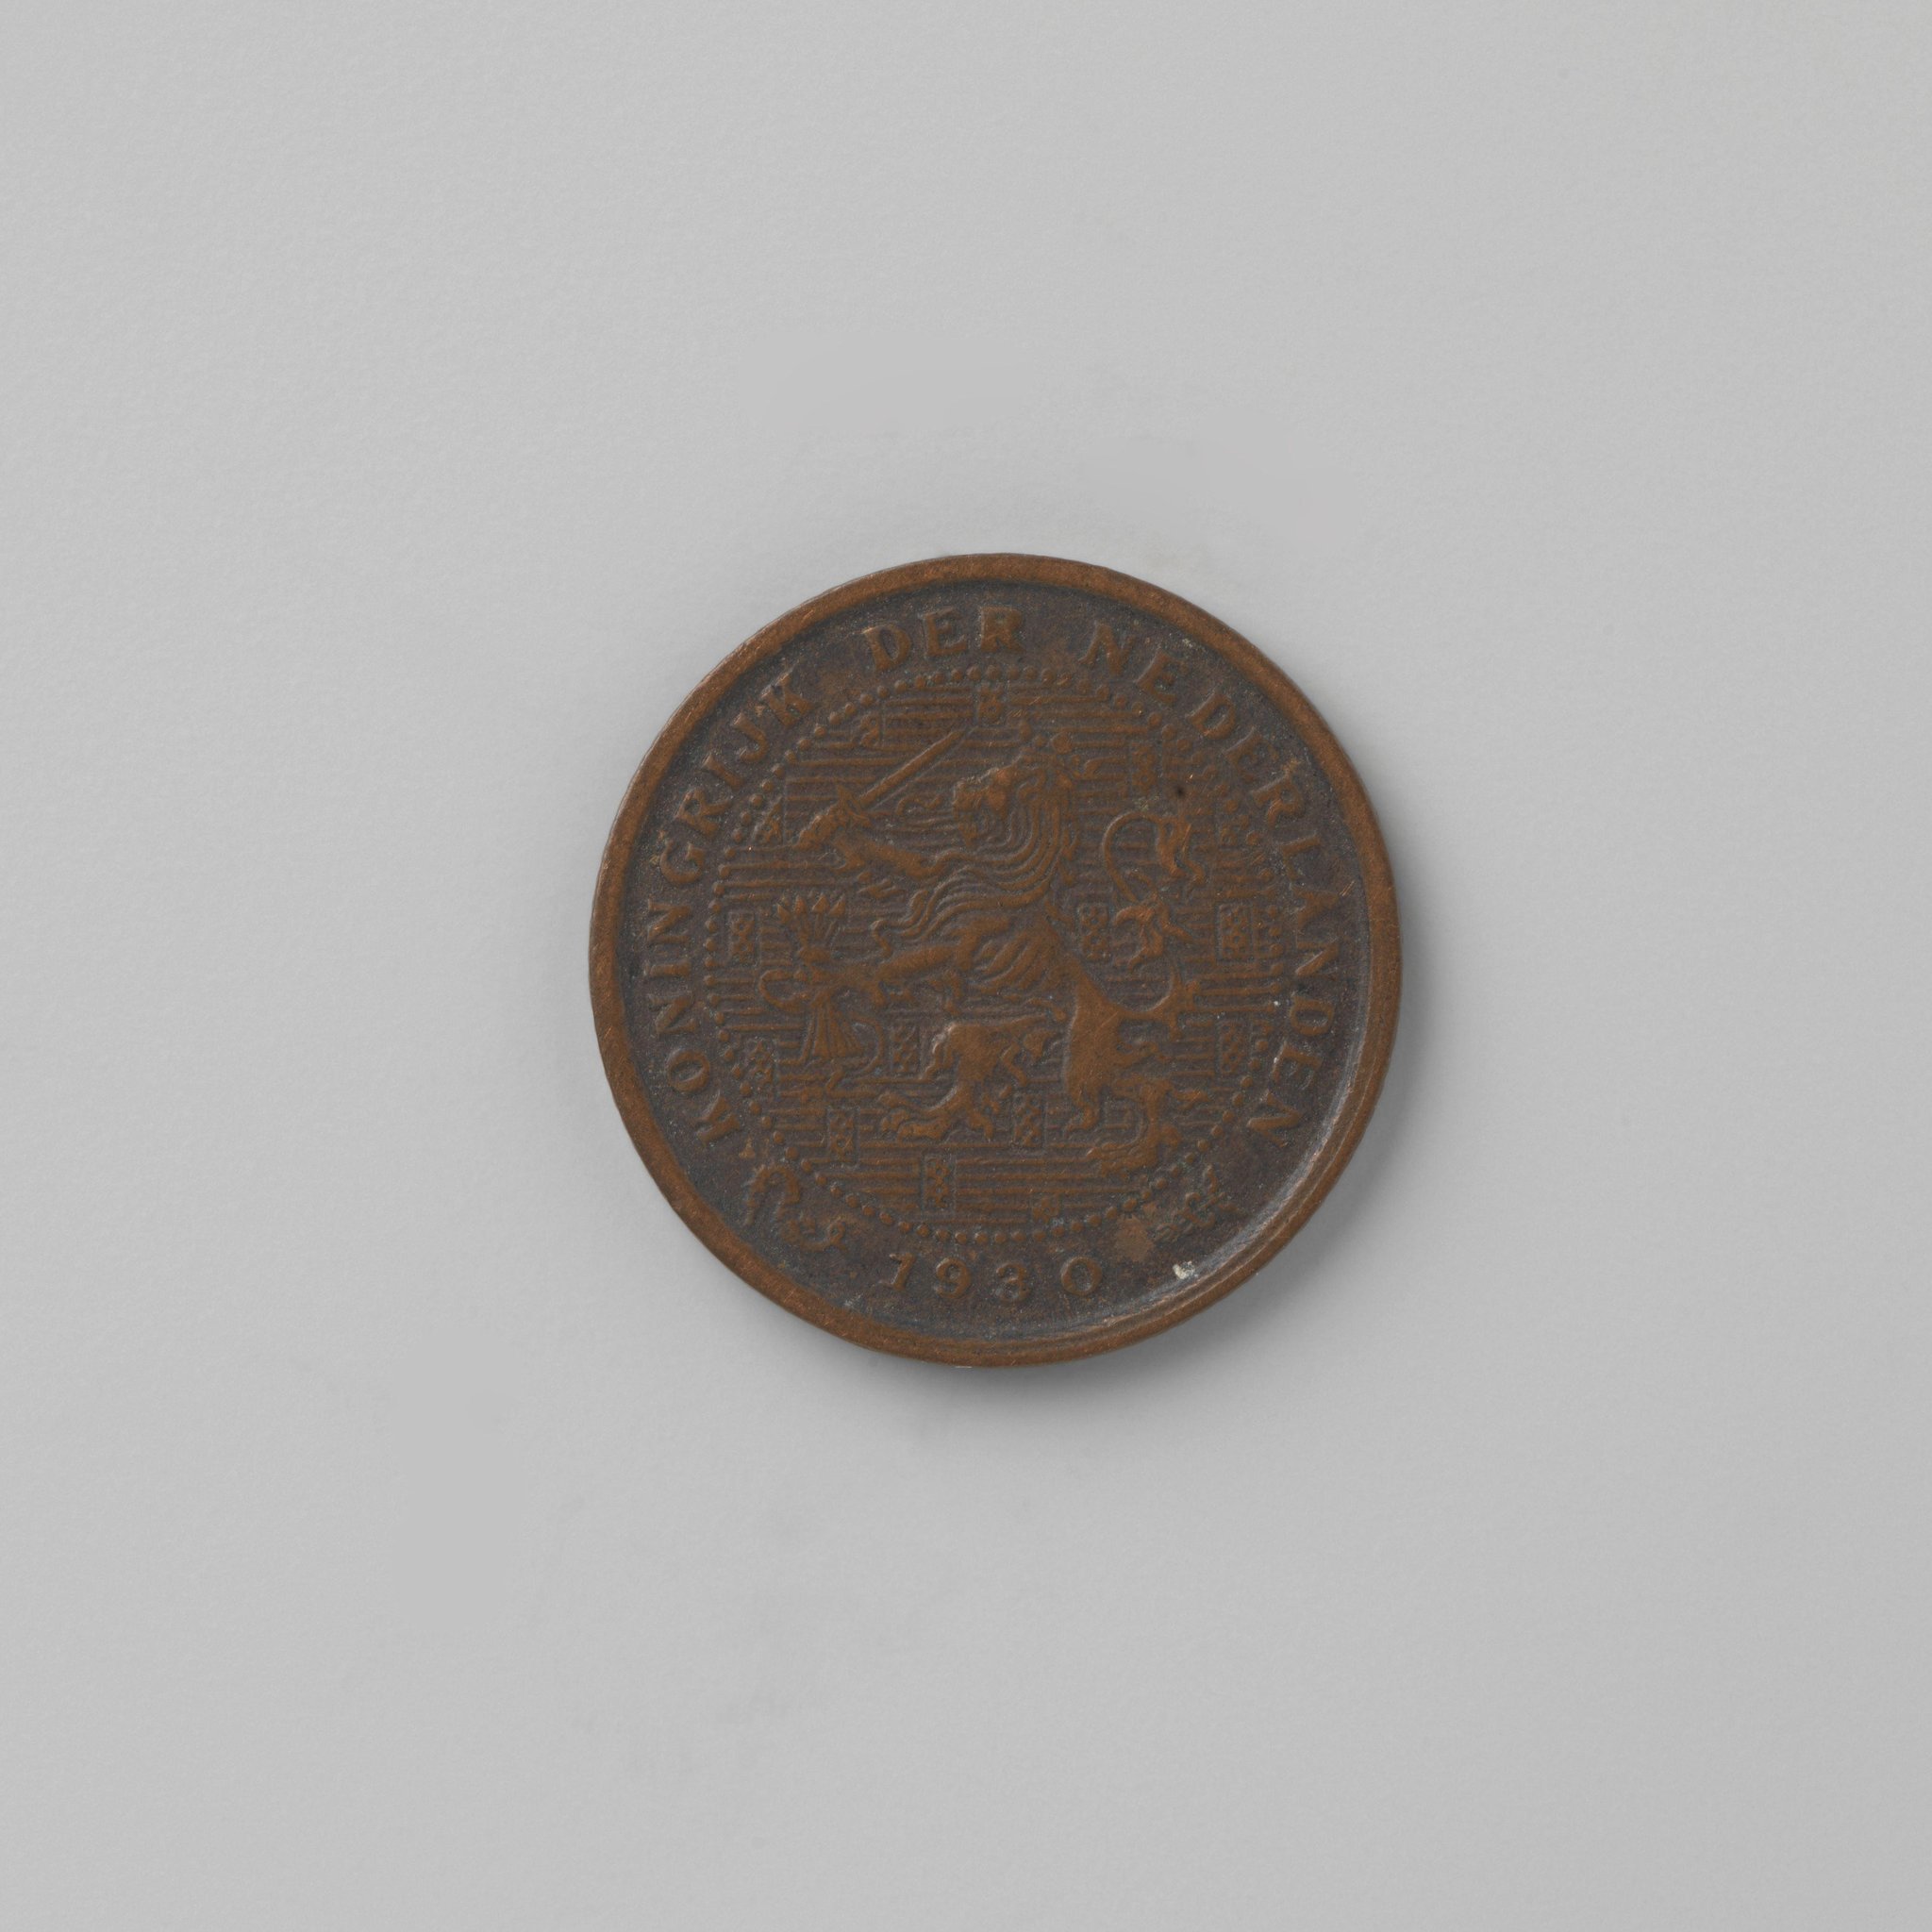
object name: coin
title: Nederland, ½ cent,1930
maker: wilhelmina of the netherlands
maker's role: print maker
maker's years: 1880-1962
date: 1930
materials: bronze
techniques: striking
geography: utrecht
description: Bronzen munt. Voorzijde: in een veld rijkswapen. Jaartal onderaan in omschrift. Keerzijde: binnen twee samengebonden oranjetakken waarde-aanduiding ½ cent. Kartelrand.